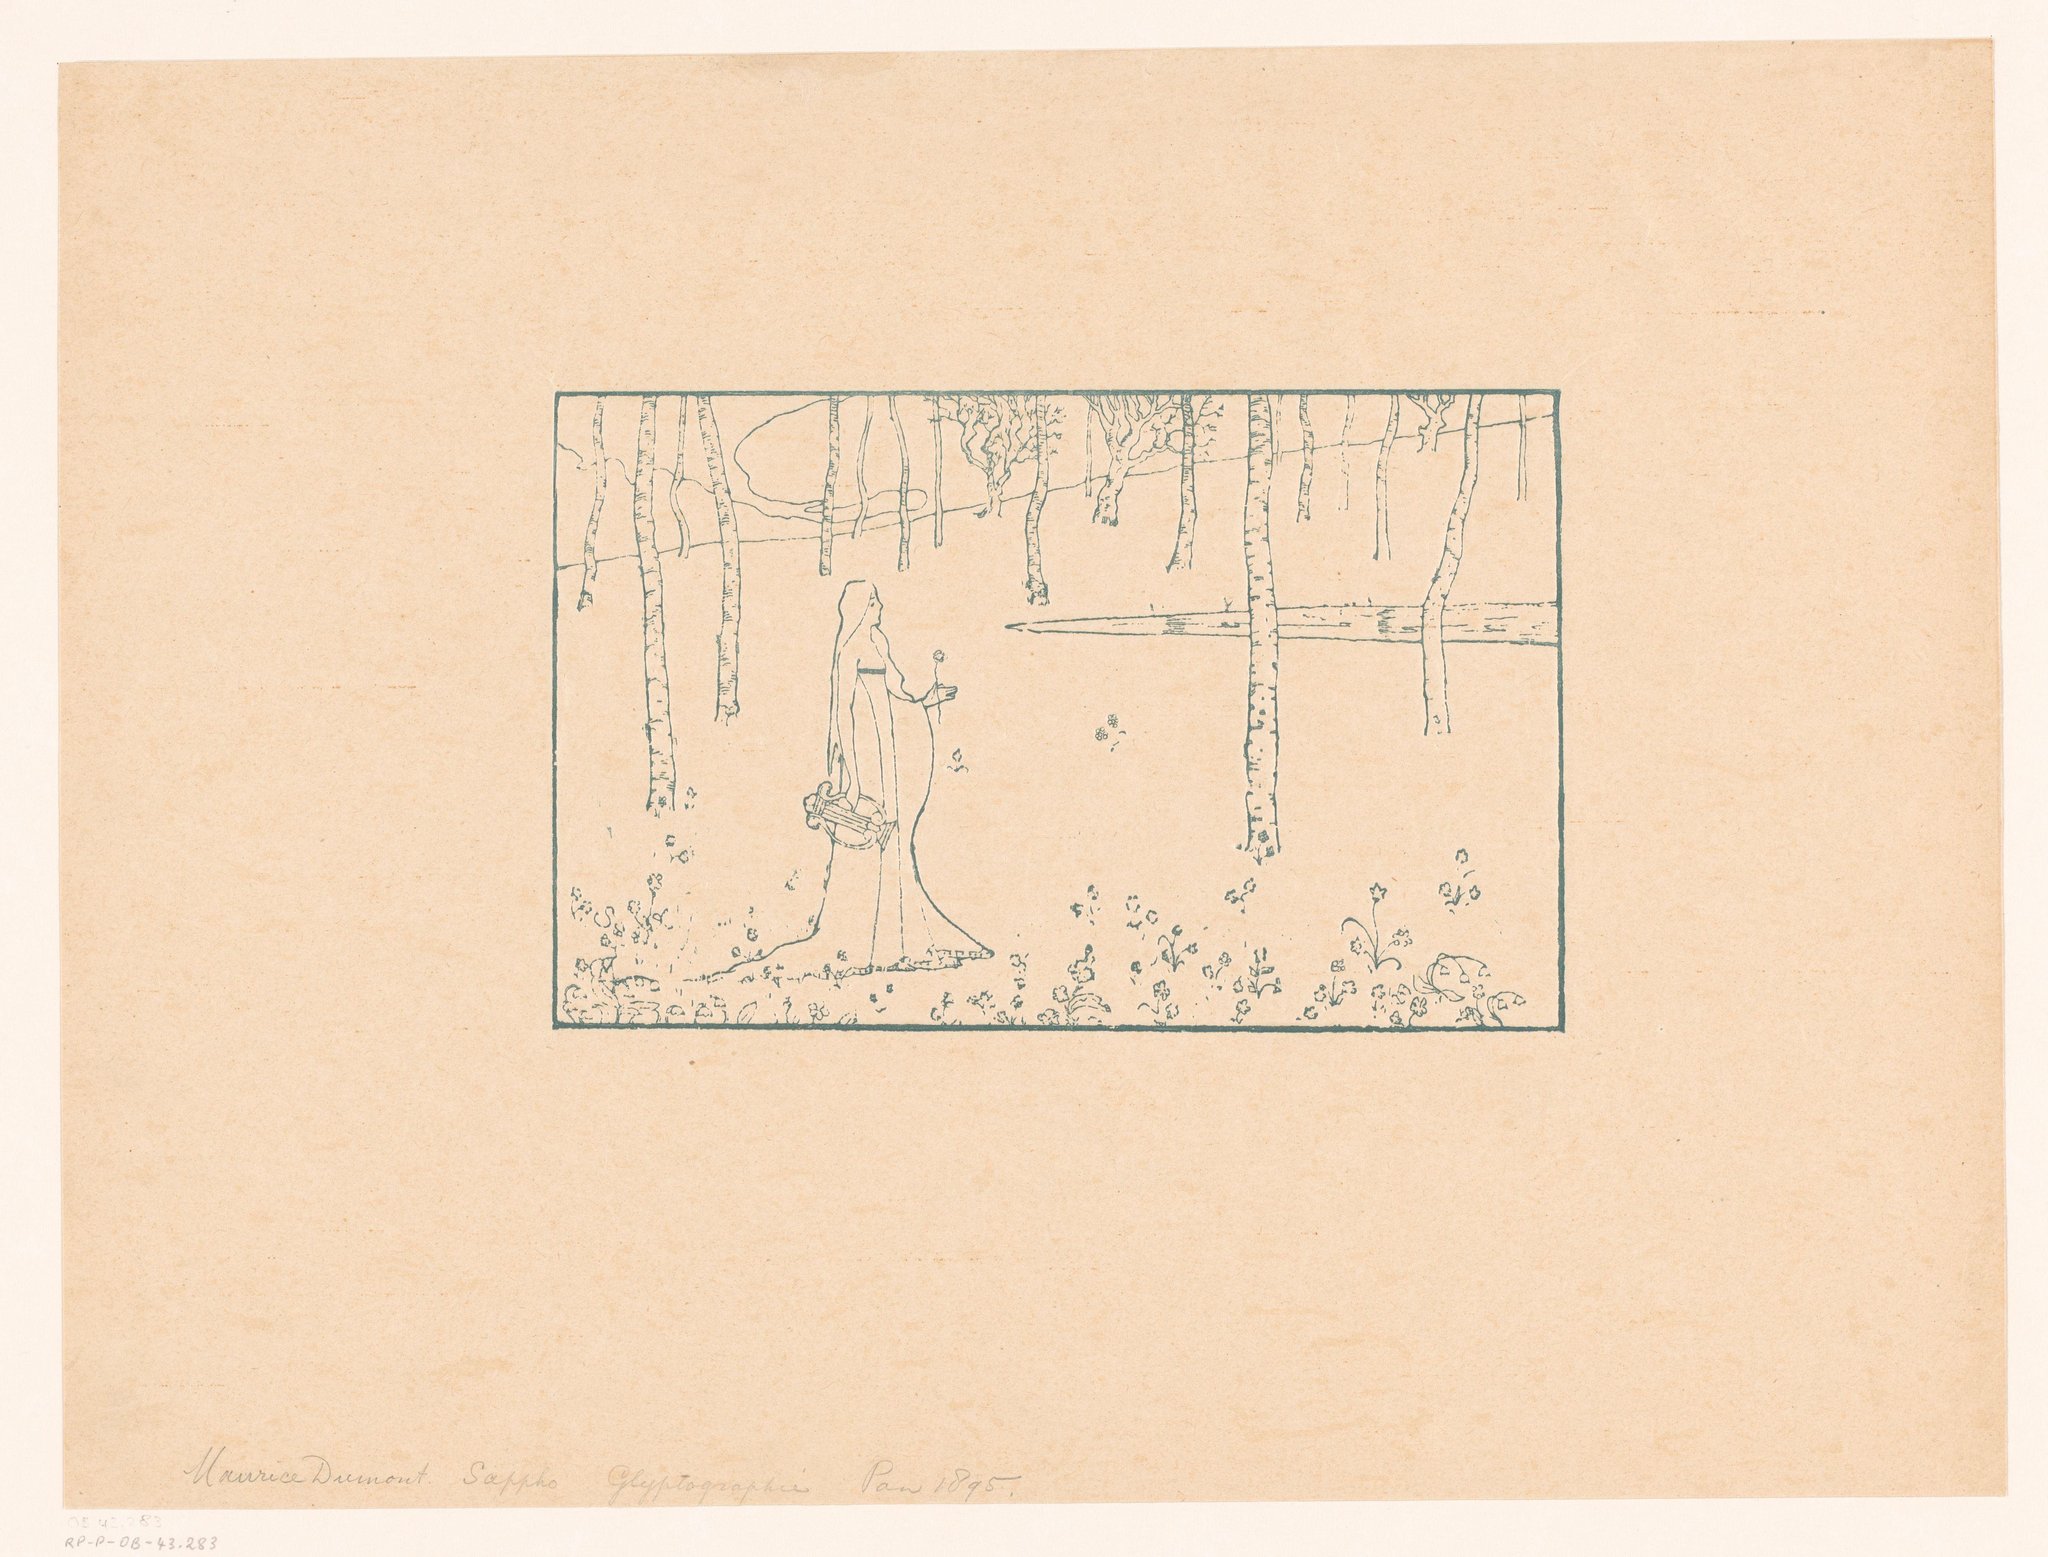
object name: print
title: Sappho in een bos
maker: maurice dumont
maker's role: print maker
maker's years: 1869-1899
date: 1879-1899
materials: paper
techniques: gypsography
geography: france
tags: (story of) sappho, the poetess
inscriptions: collector's mark: Lugt 2228